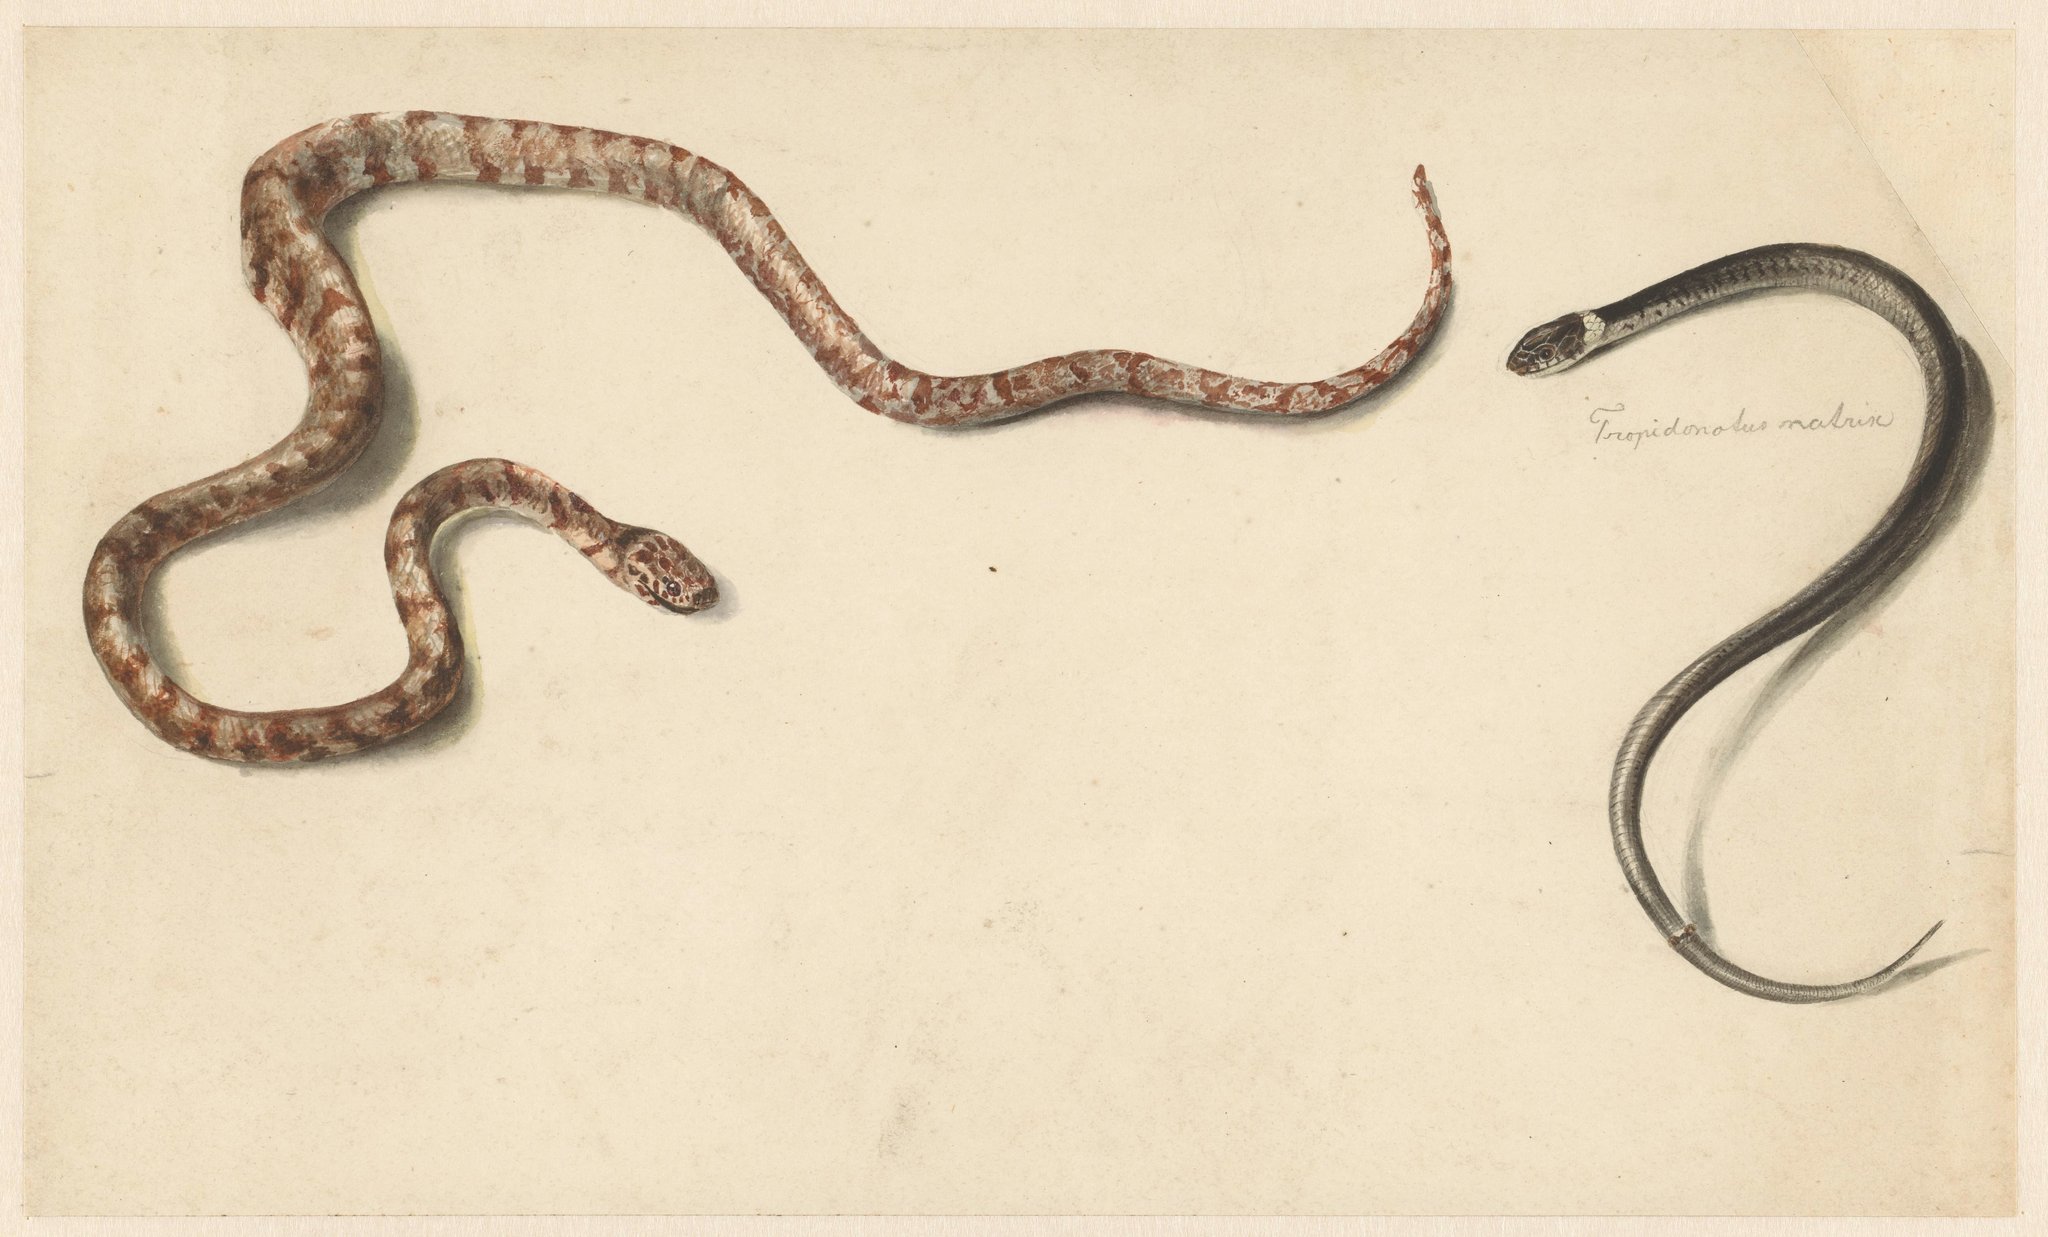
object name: watercolor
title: Twee tropische slangen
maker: albertus steenbergen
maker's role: draughtsman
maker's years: 1814-1900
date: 1824-1900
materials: ink, paper, pencil, watercolor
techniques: brush, pen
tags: snakes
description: Twee tropische slangen, de rechter gemerkt: Tropidonotus Natrix.